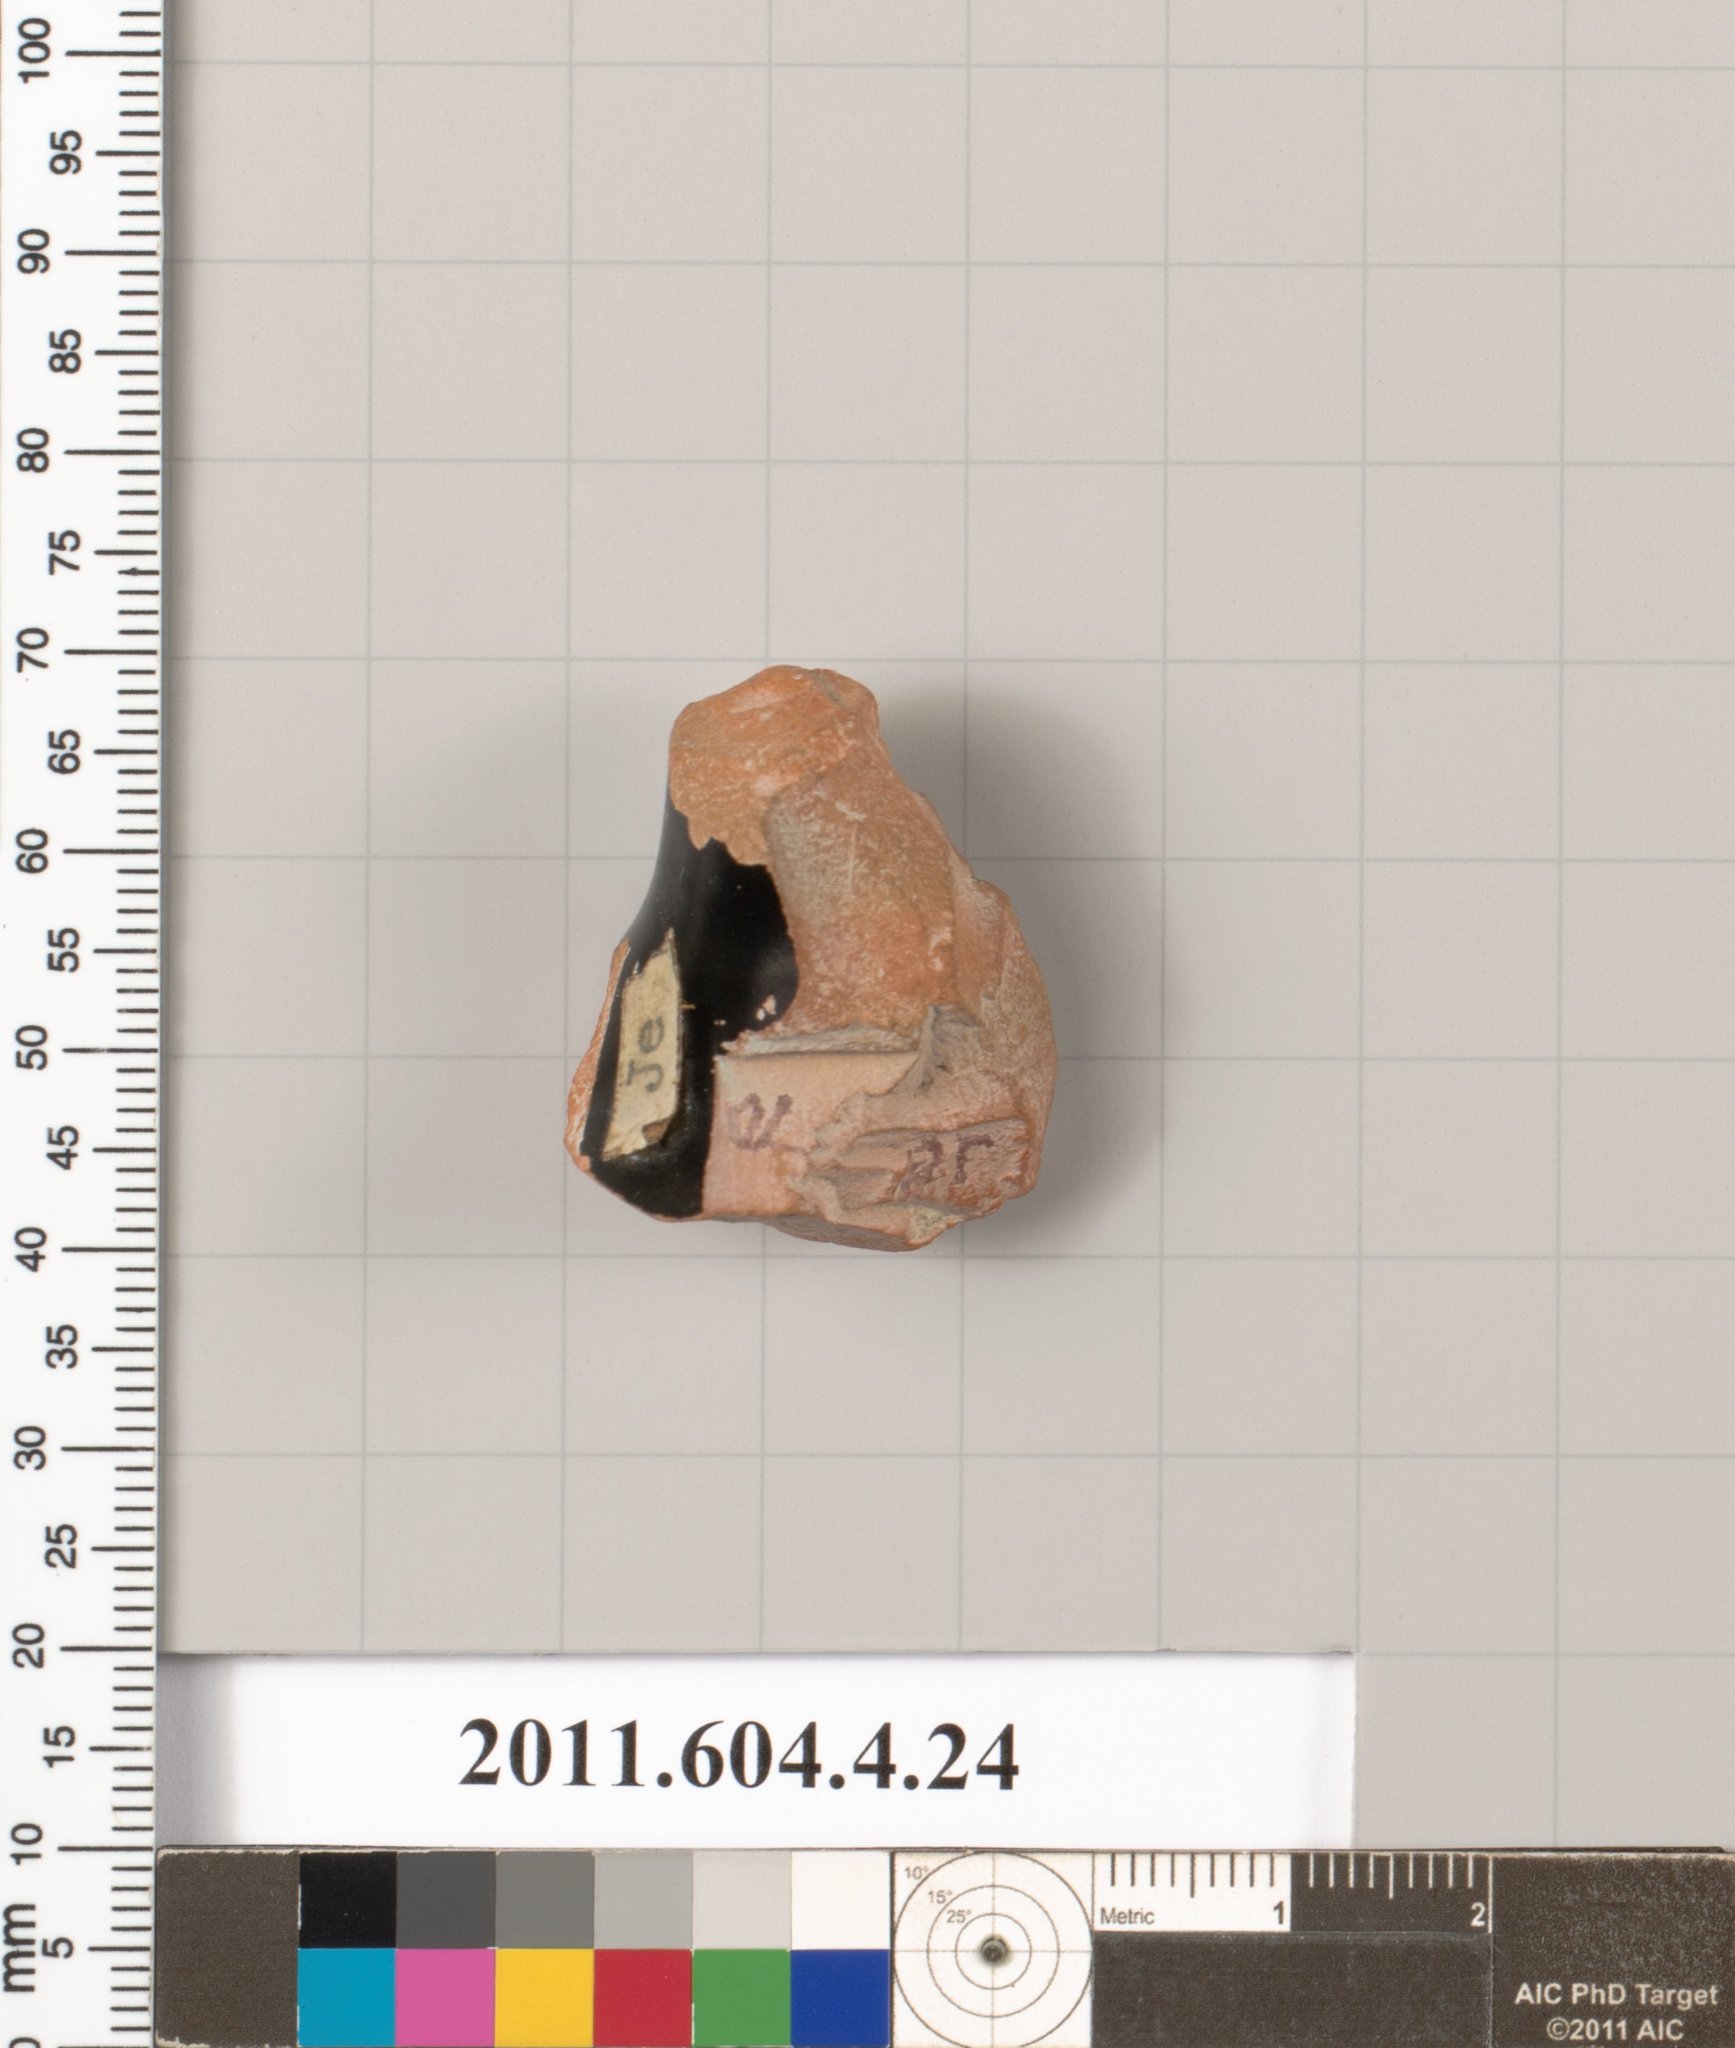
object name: kylix fragment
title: Terracotta fragment of a kylix (drinking cup)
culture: greek, attic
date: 534-468 BCE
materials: terracotta